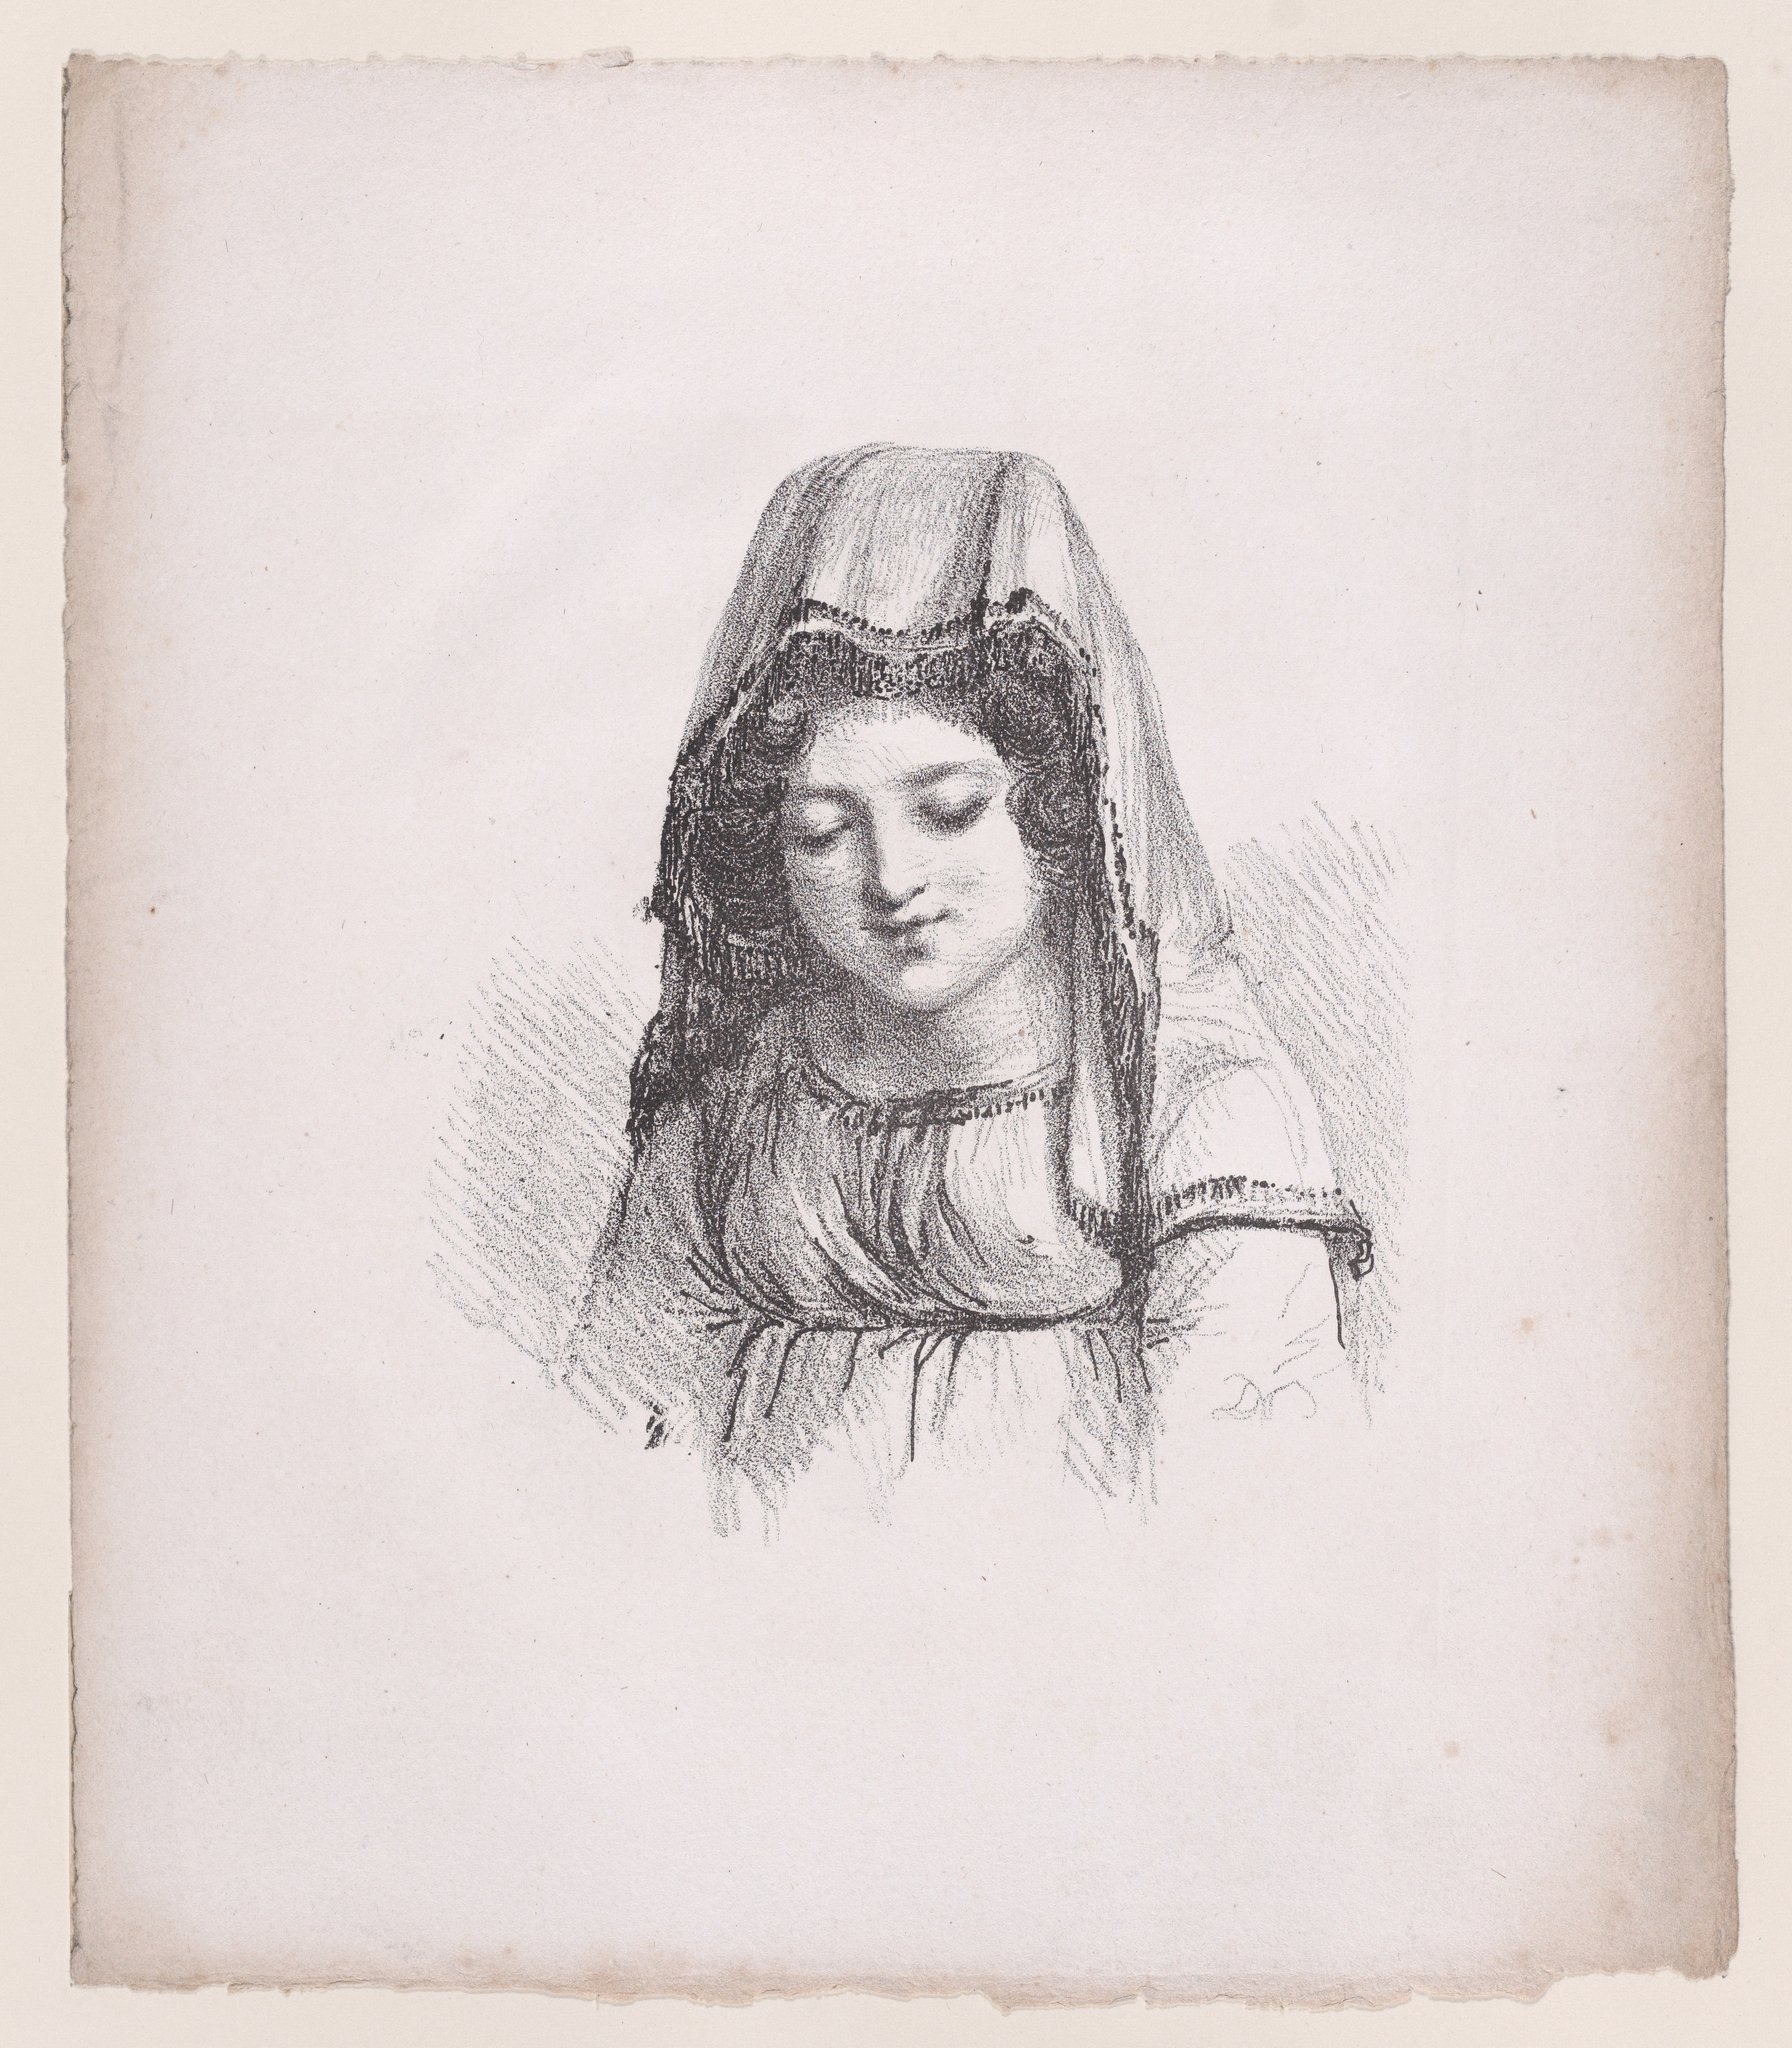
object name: print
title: Young girl in peasant dress with veil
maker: baron dominique vivant denon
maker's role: artist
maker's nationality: french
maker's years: 1747-1825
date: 1800-1825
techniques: lithograph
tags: women